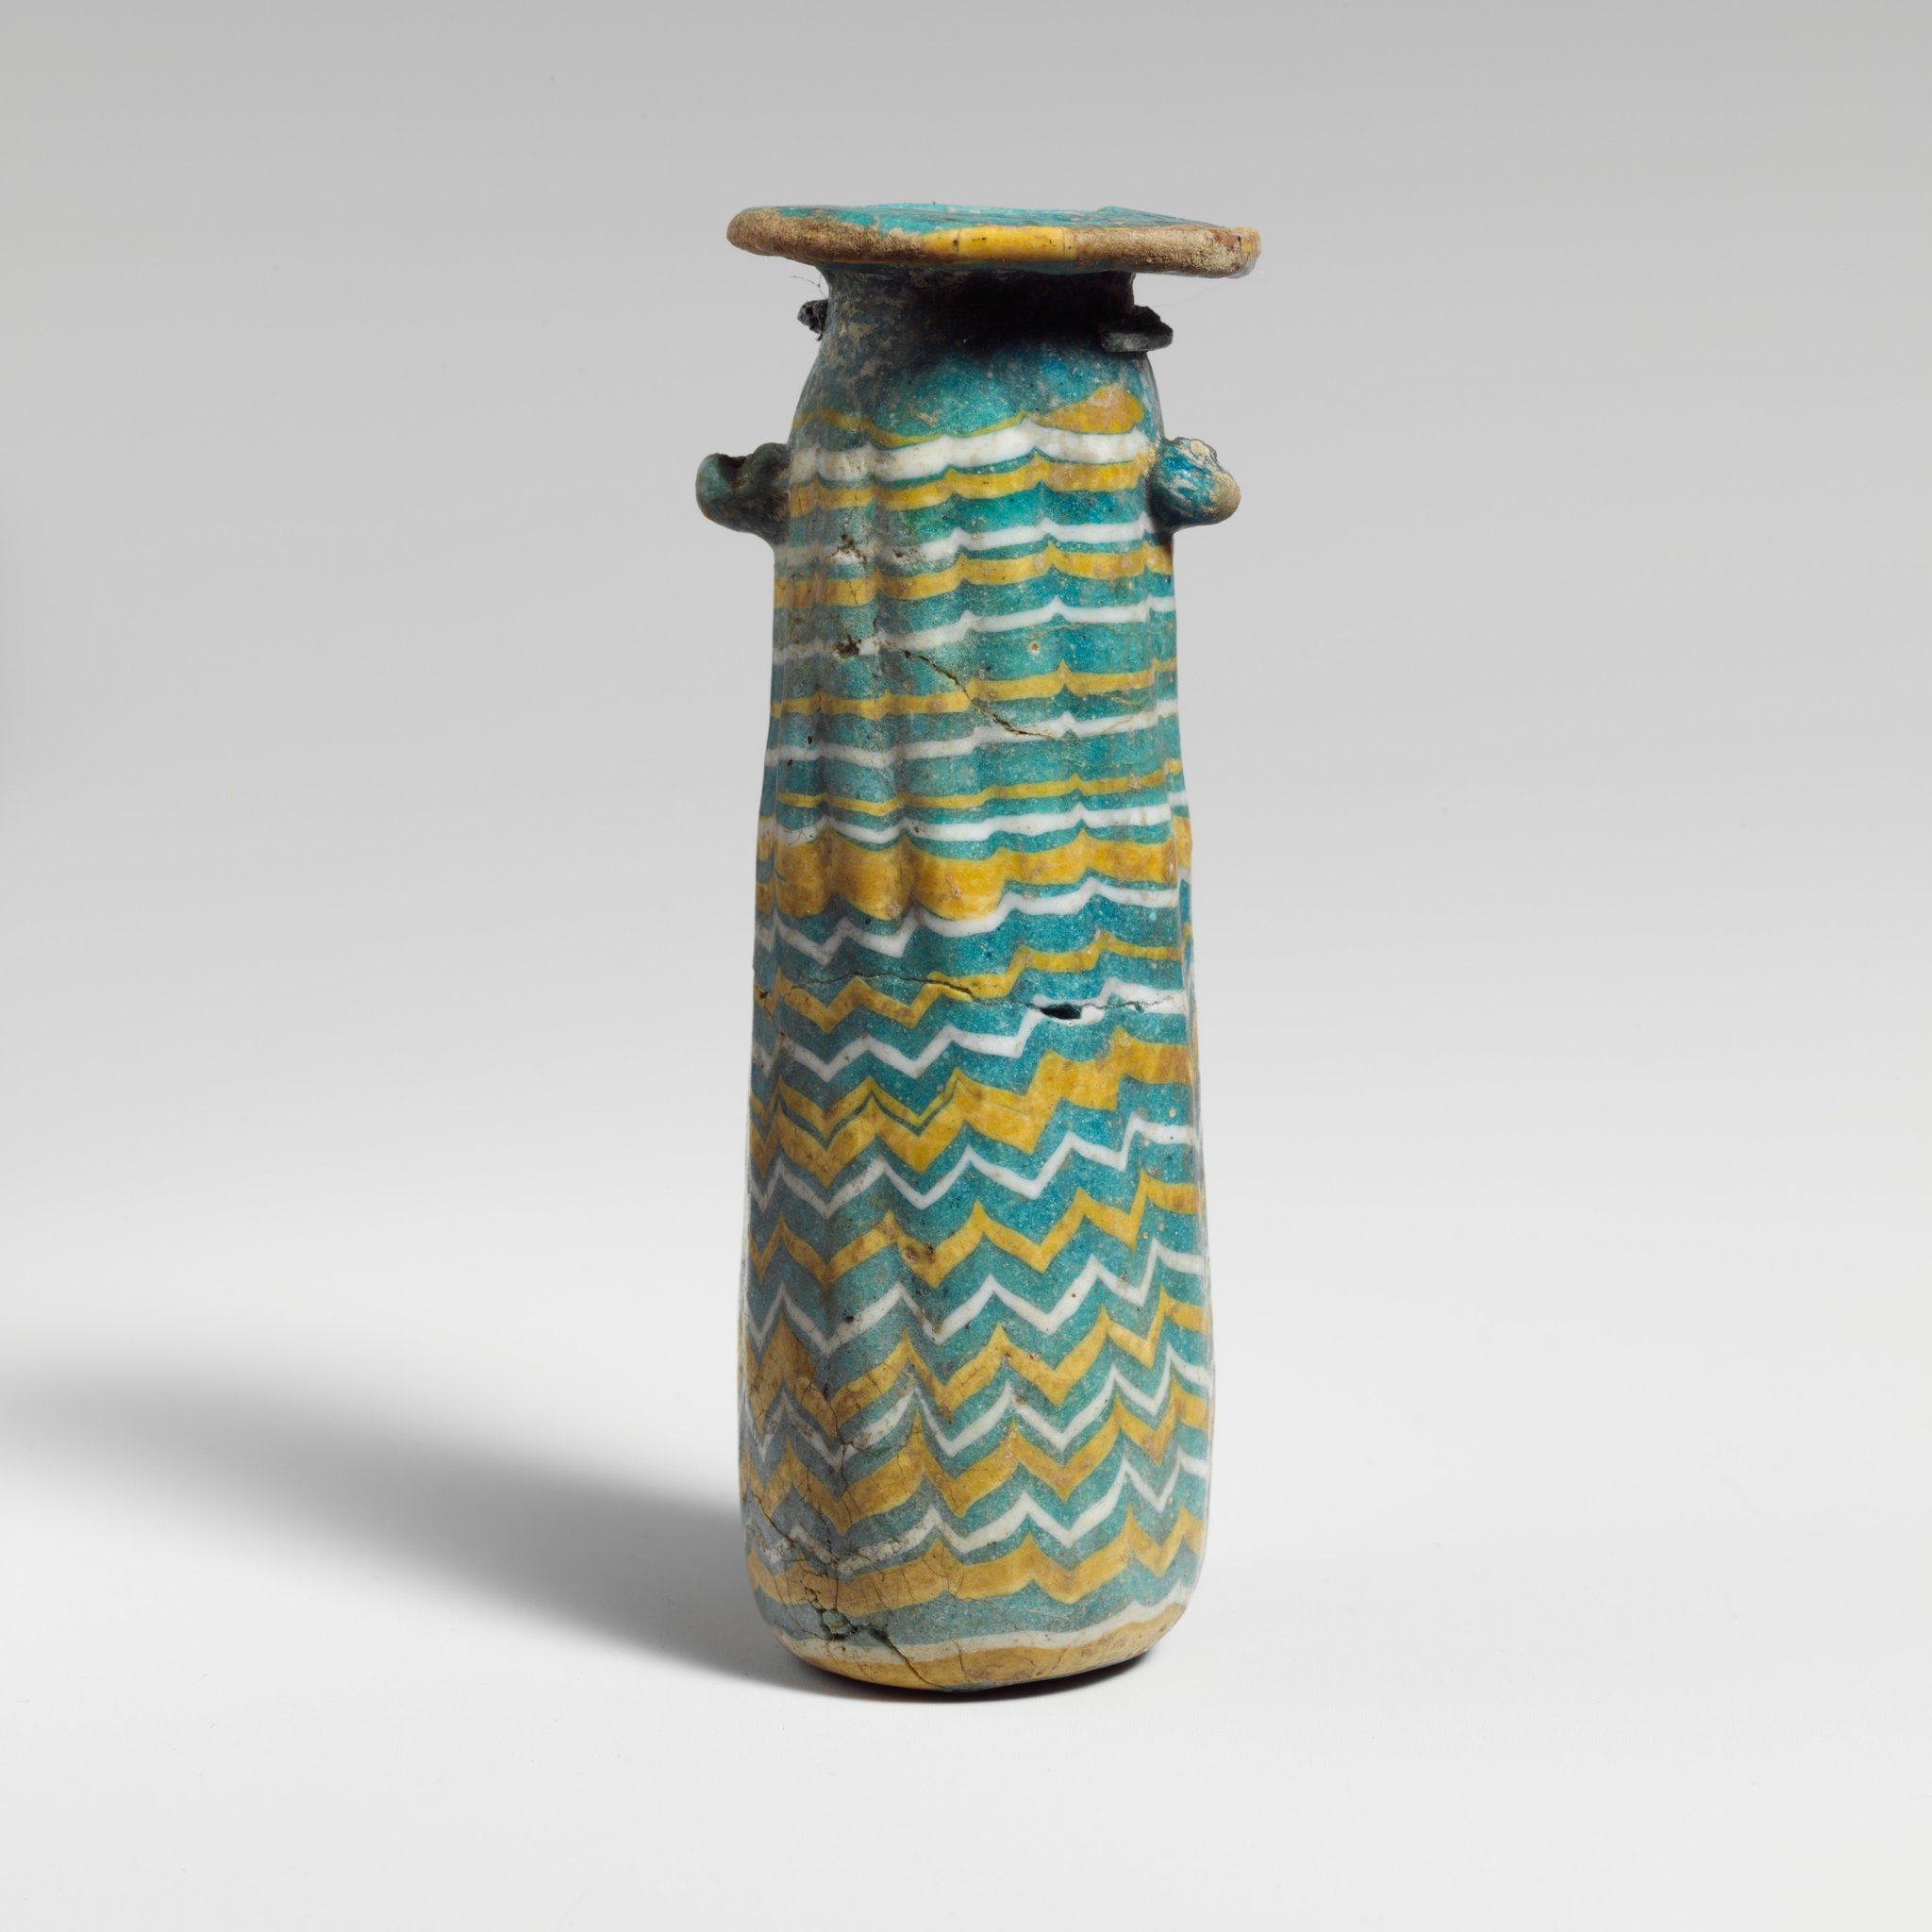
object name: alabastron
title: Glass alabastron (perfume bottle)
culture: greek, eastern mediterranean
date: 334-268 BCE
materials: glass